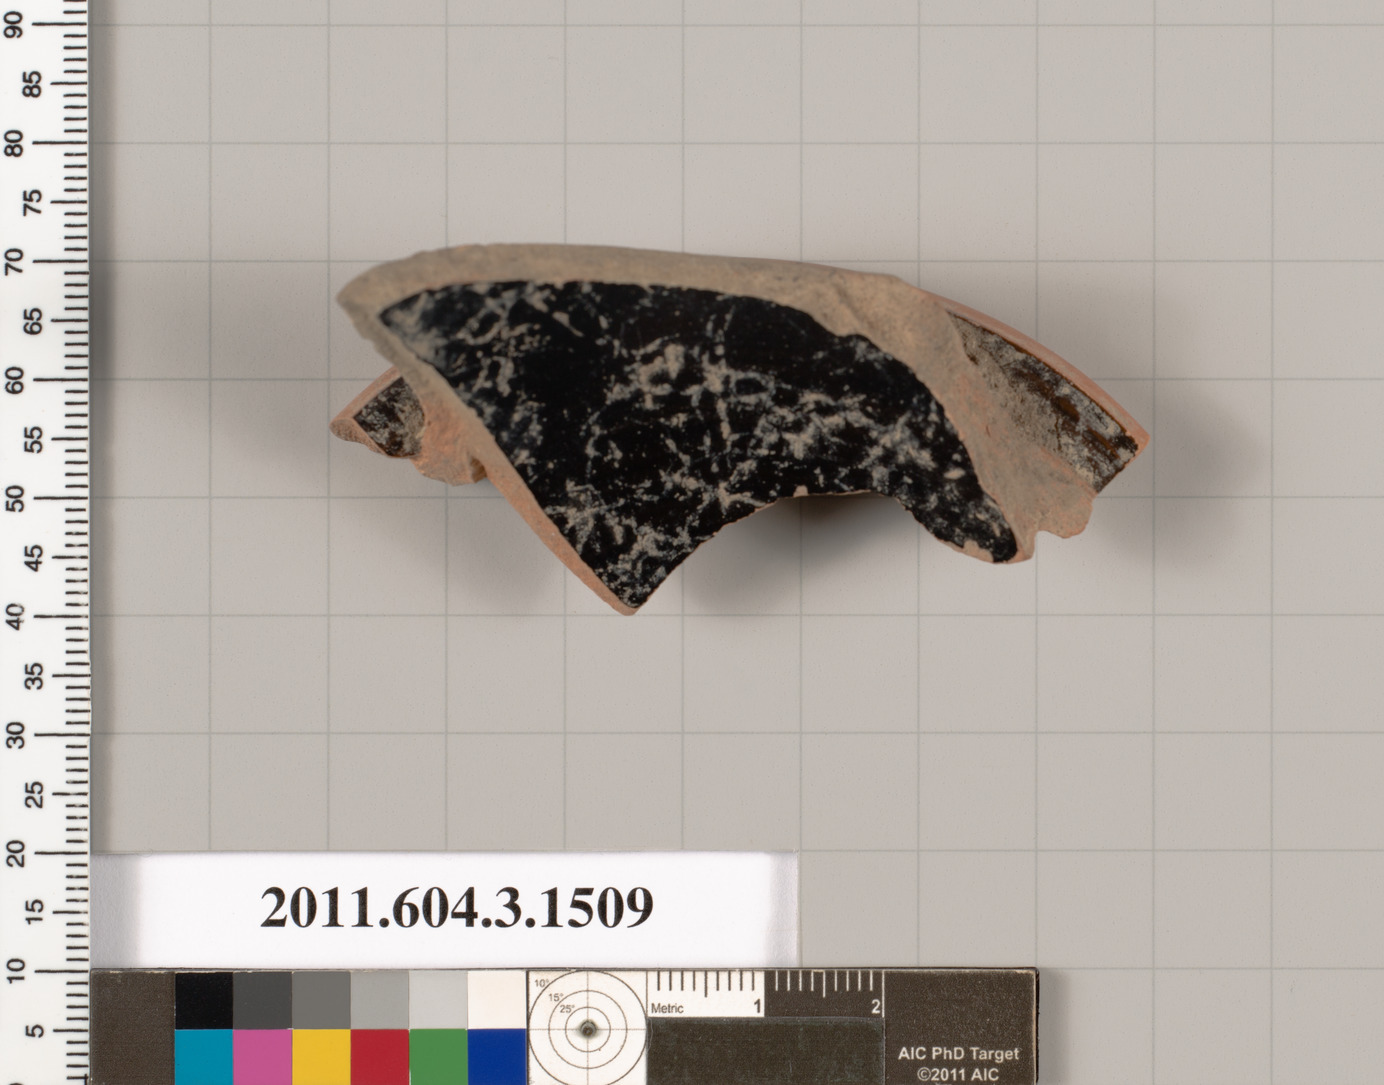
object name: skyphos fragment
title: Terracotta fragment of a skyphos (deep drinking cup)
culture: greek, attic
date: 600-401 BCE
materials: terracotta